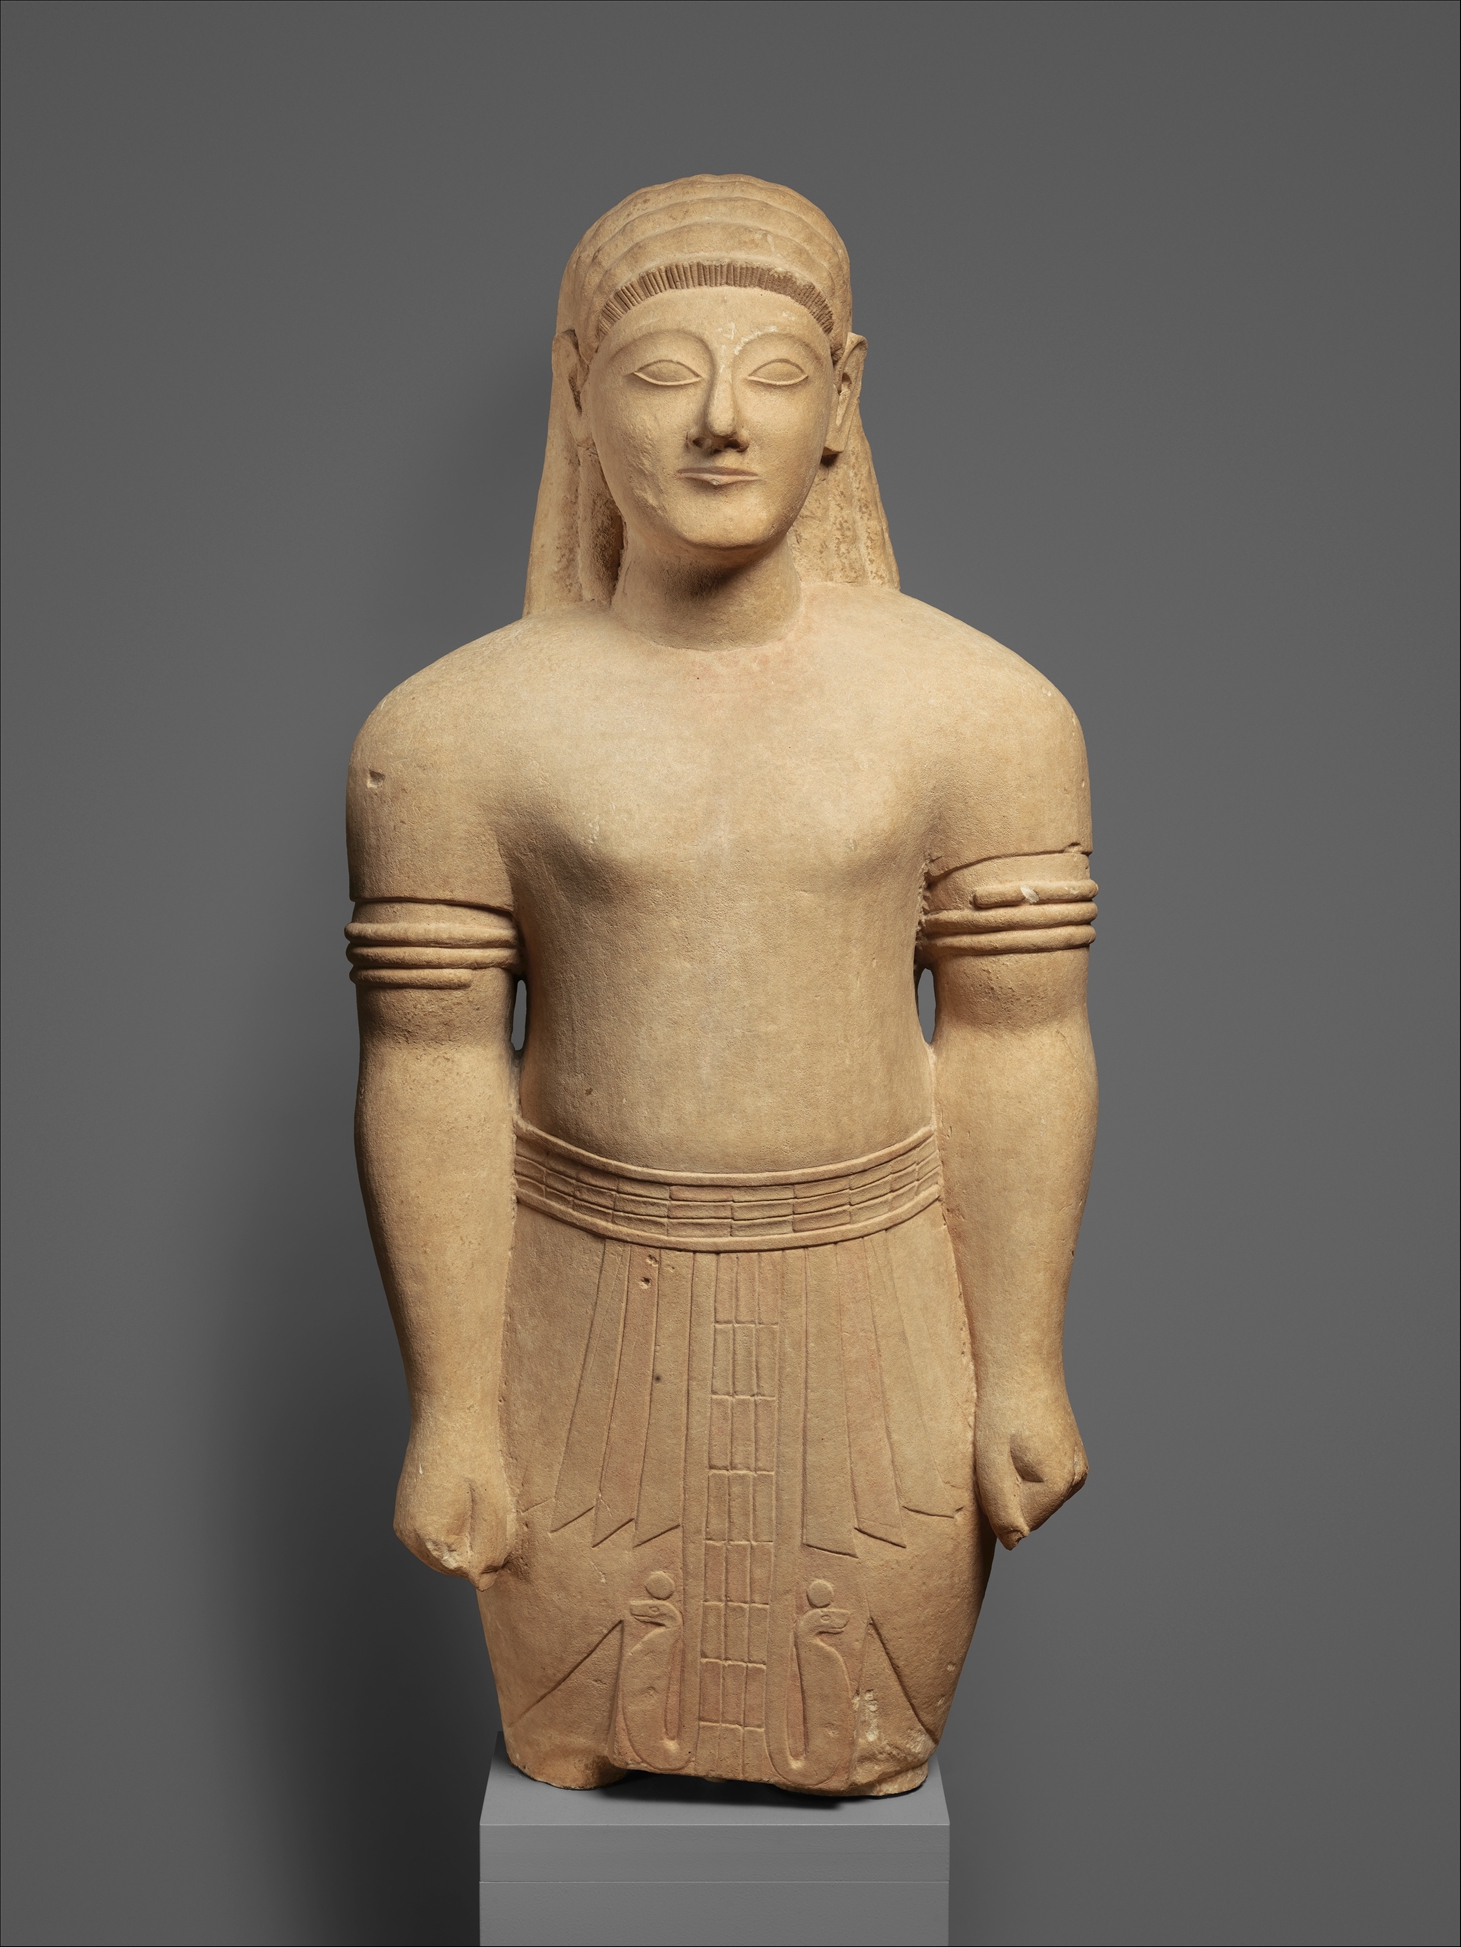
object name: statue of a man in egyptian dress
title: Limestone male figure in Egyptian dress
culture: cypriot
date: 567-535 BCE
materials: limestone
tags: men